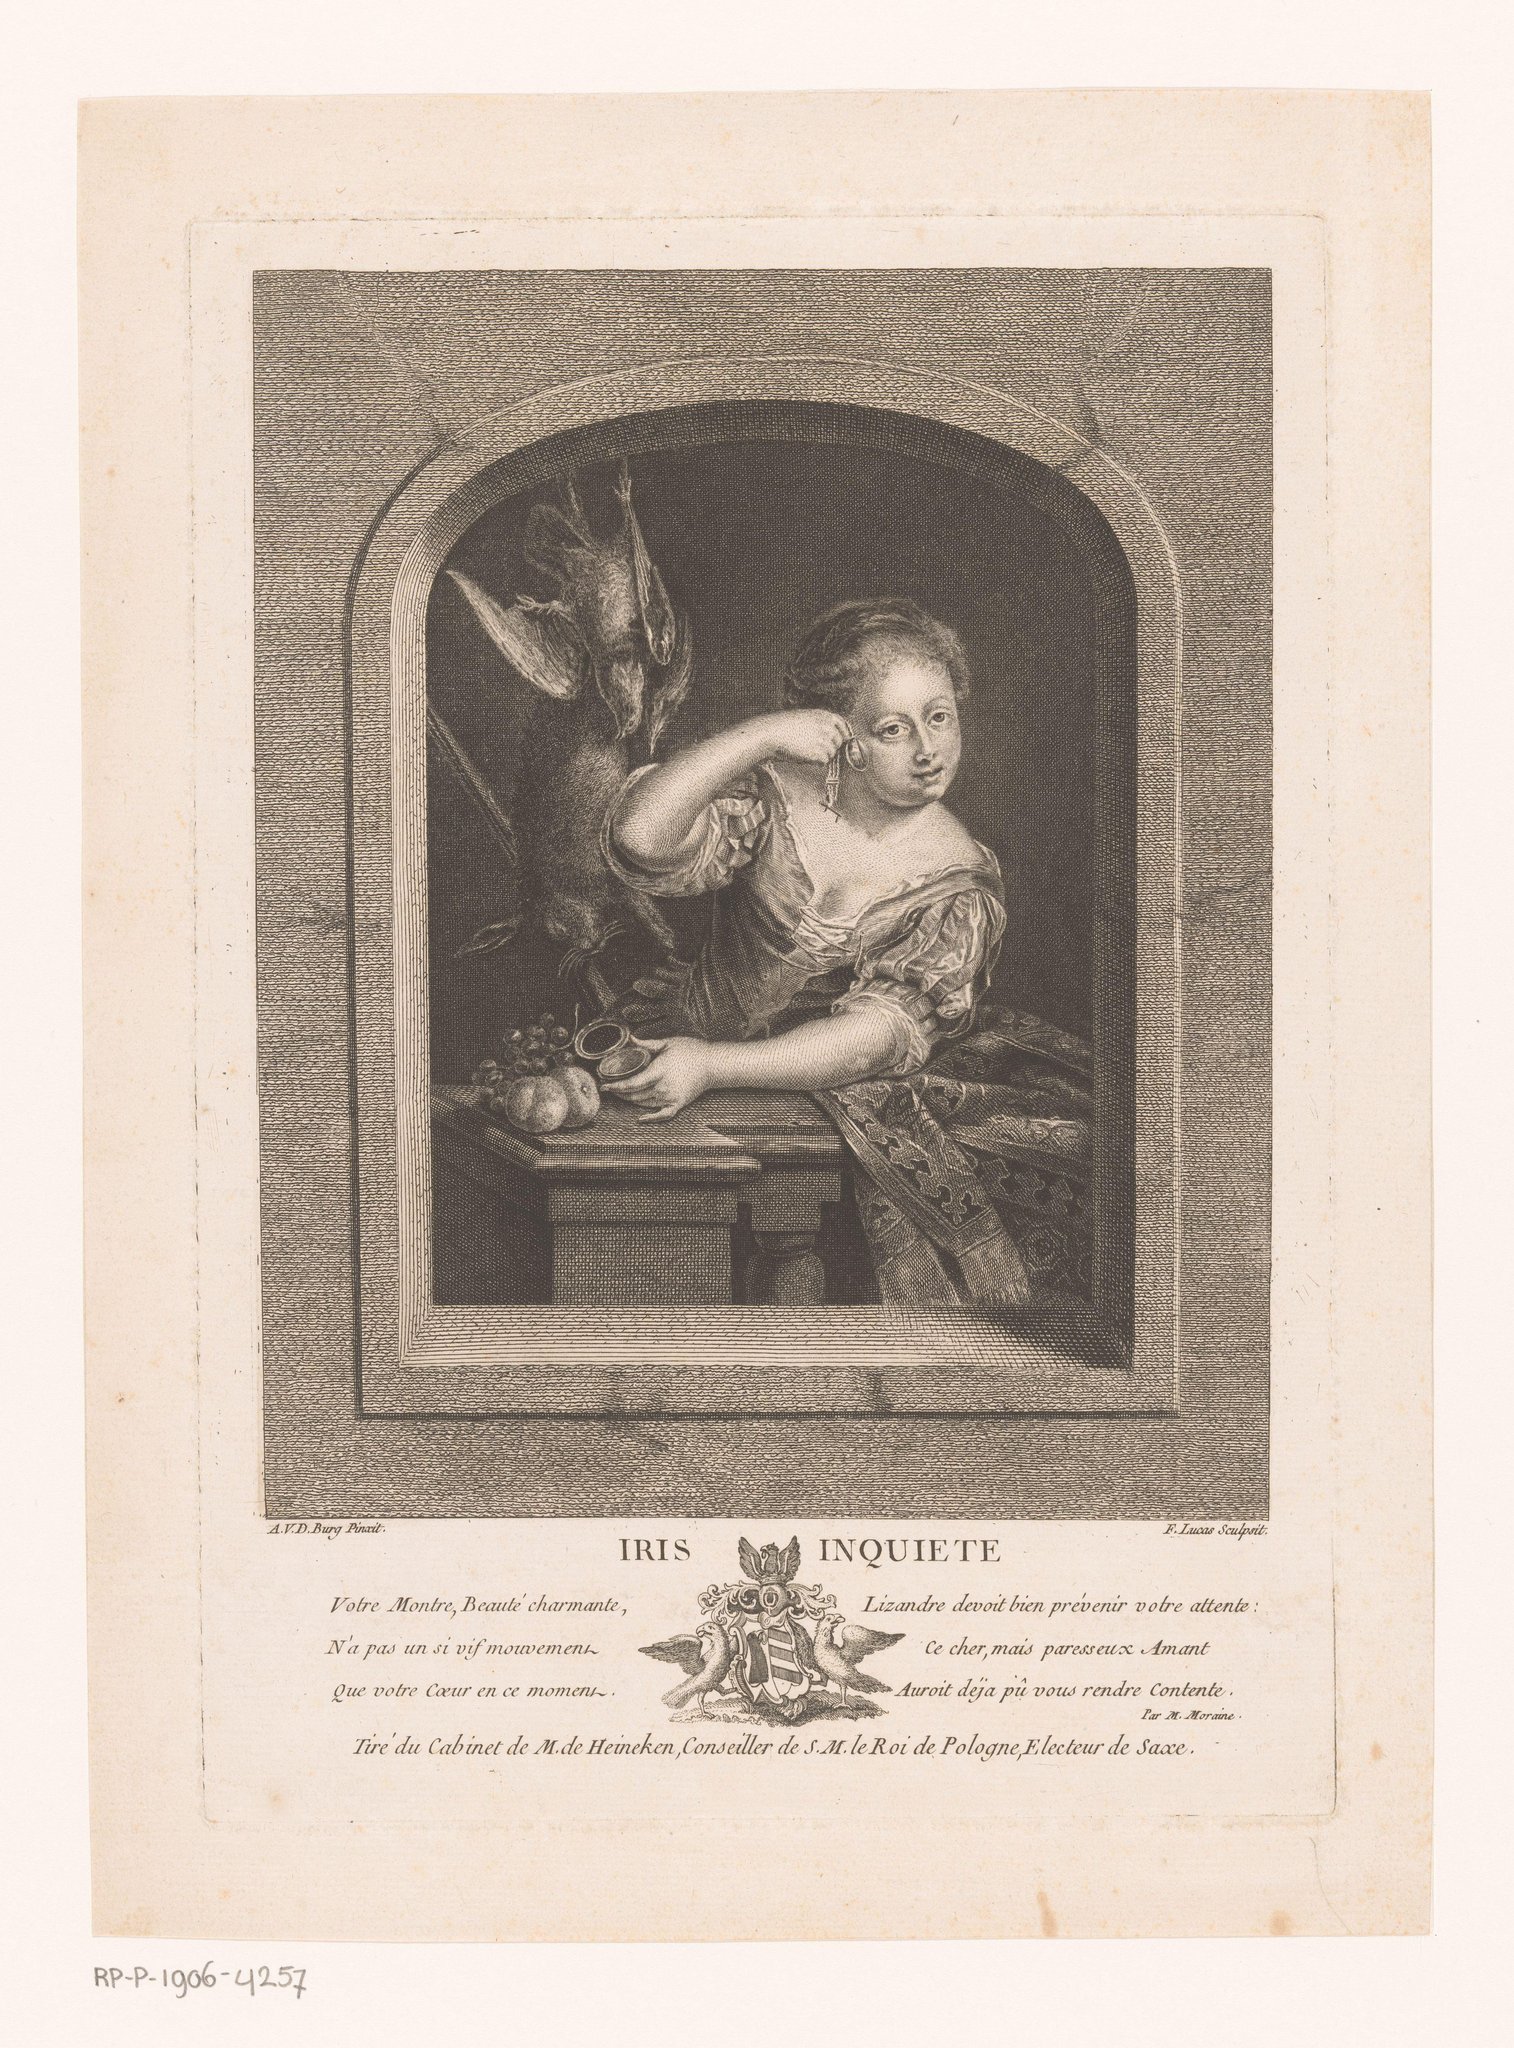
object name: print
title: Iris met jachtstilleven en horloge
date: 1725-1825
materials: paper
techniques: engraving, etching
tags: 'vanitas' symbols, watch, group of various hunted animals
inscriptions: collector's mark: Lugt 2228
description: Onder de voorstelling een gedicht over Iris' geliefde Lisander en de vergankelijkheid van de liefde.